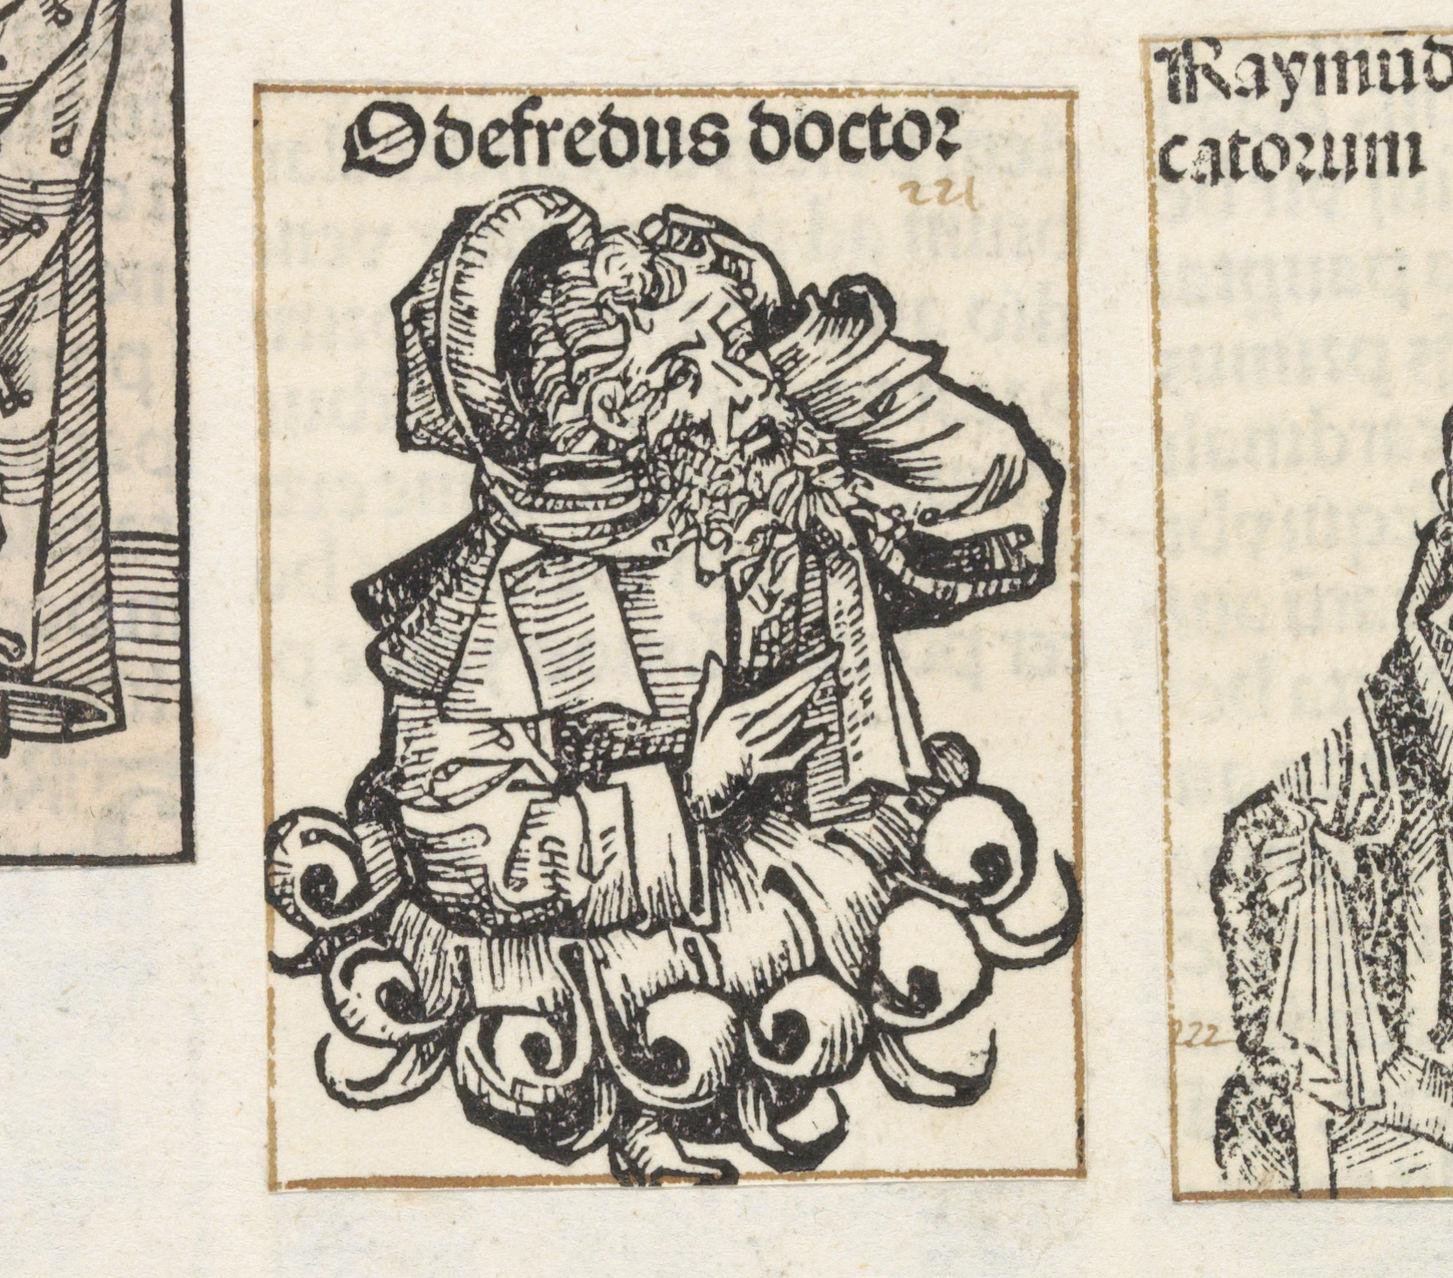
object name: print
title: Liber Chronicarum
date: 1493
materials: paper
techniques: letterpress printing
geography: nuremberg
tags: roffredus van benevento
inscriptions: inscription: ‘221’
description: De houtsnede wordt herhaaldelijk gebruikt als boekillustratie in de Liber Chronicarum (of Neurenbergkroniek) van Hartmann Schedel, verschenen in het Latijn en Duits in 1493. Zie de Latijnse uitgave, folio 211r.